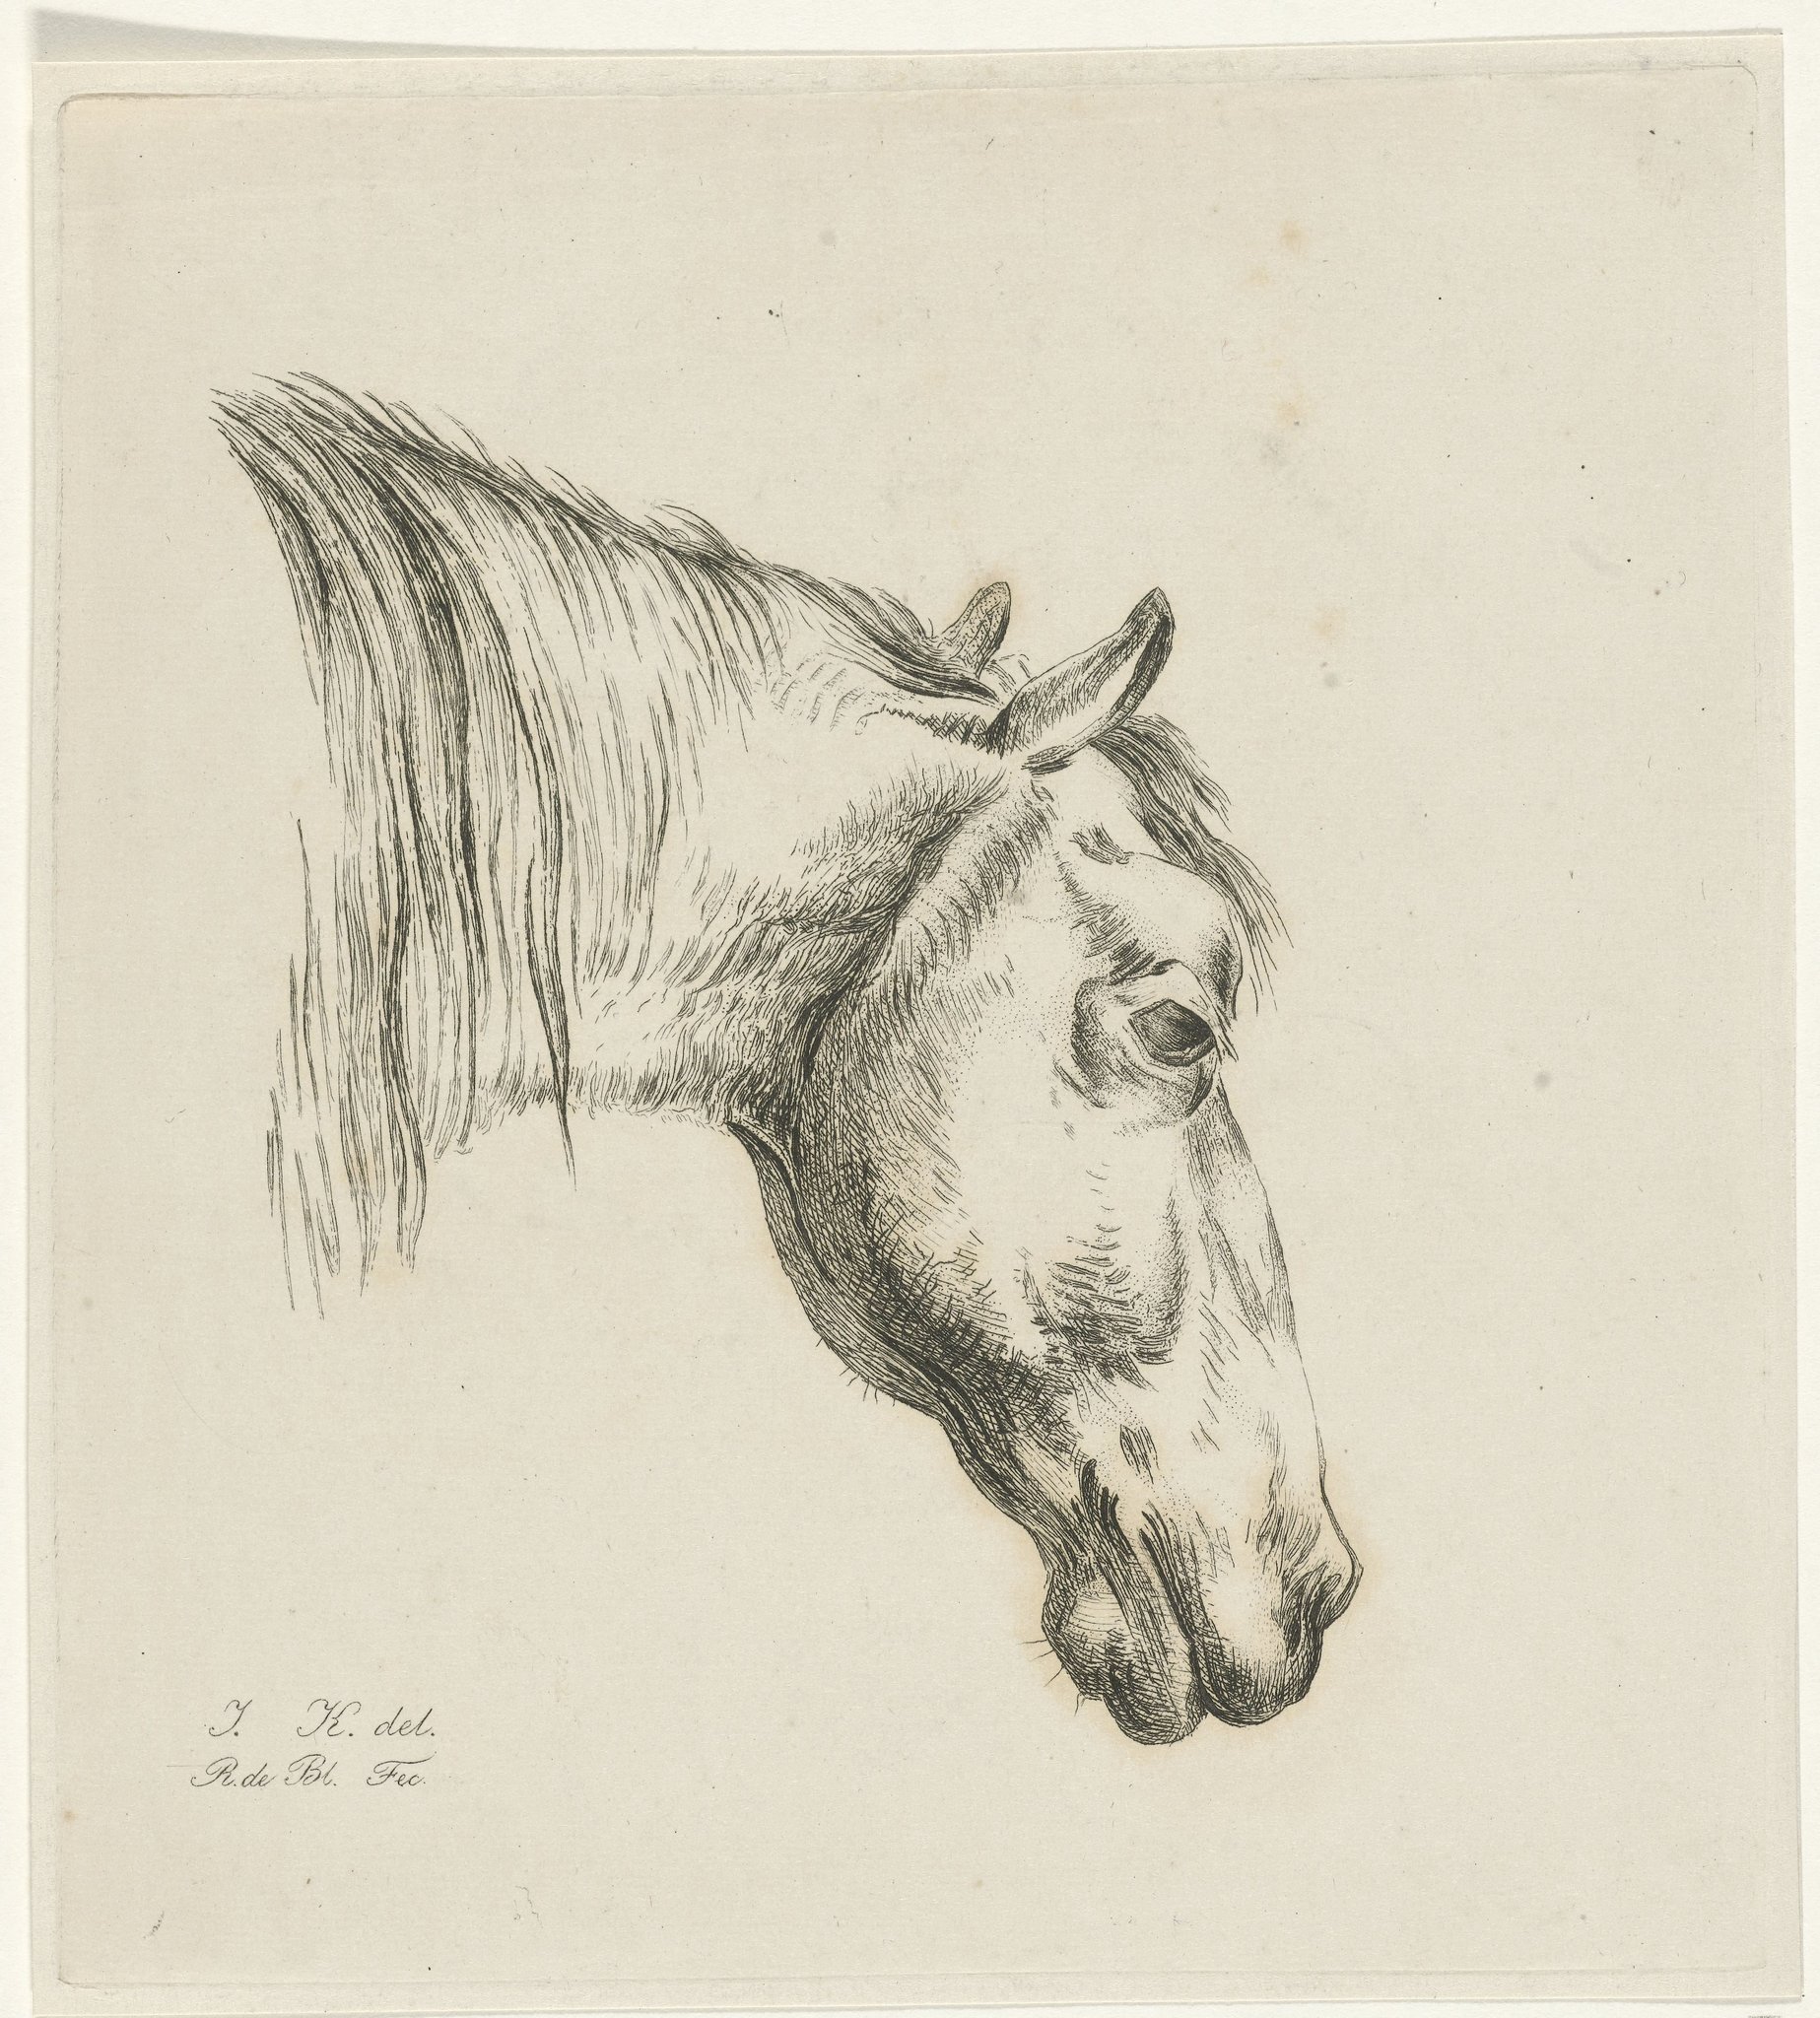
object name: print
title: Hoofd van een paard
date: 1796-1856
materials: paper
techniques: etching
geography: vaassen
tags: horse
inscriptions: collector's mark: Lugt 2228